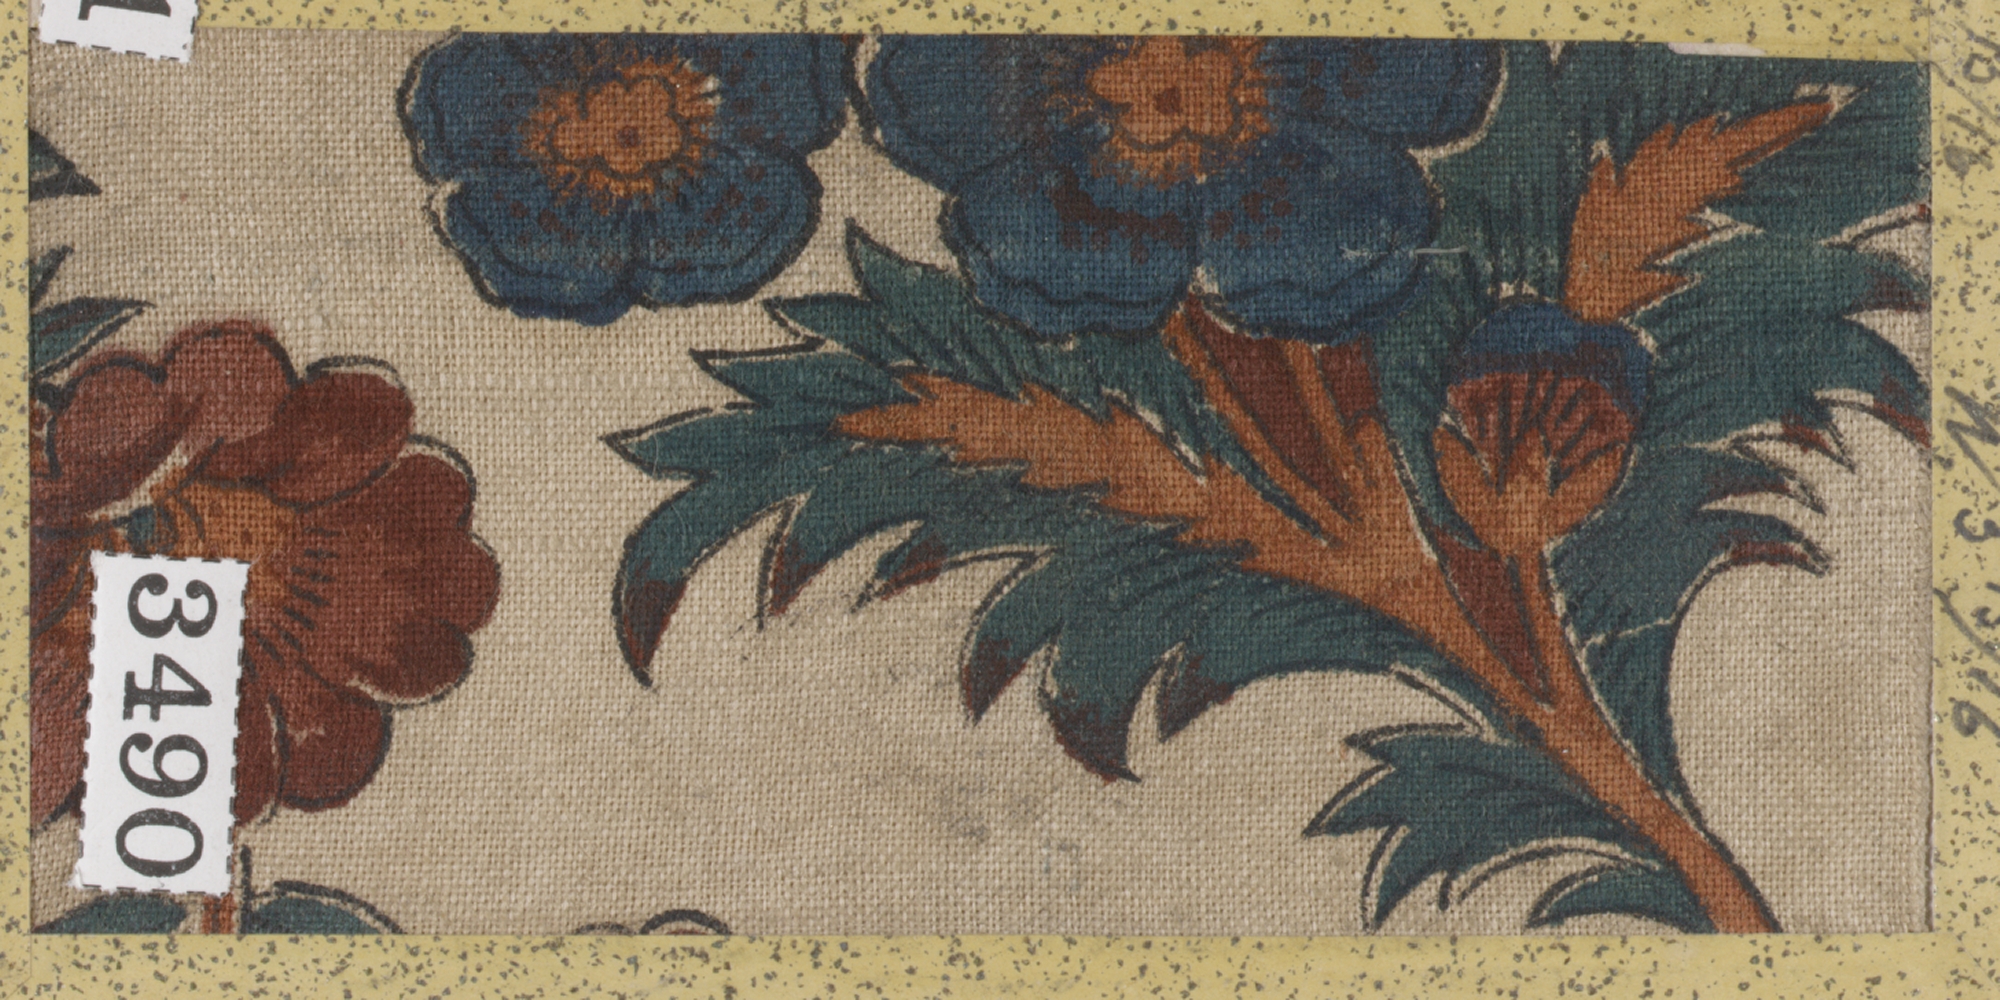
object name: sample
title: Textile Sample from Sample Book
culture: japanese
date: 1801-1900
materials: silk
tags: leaves